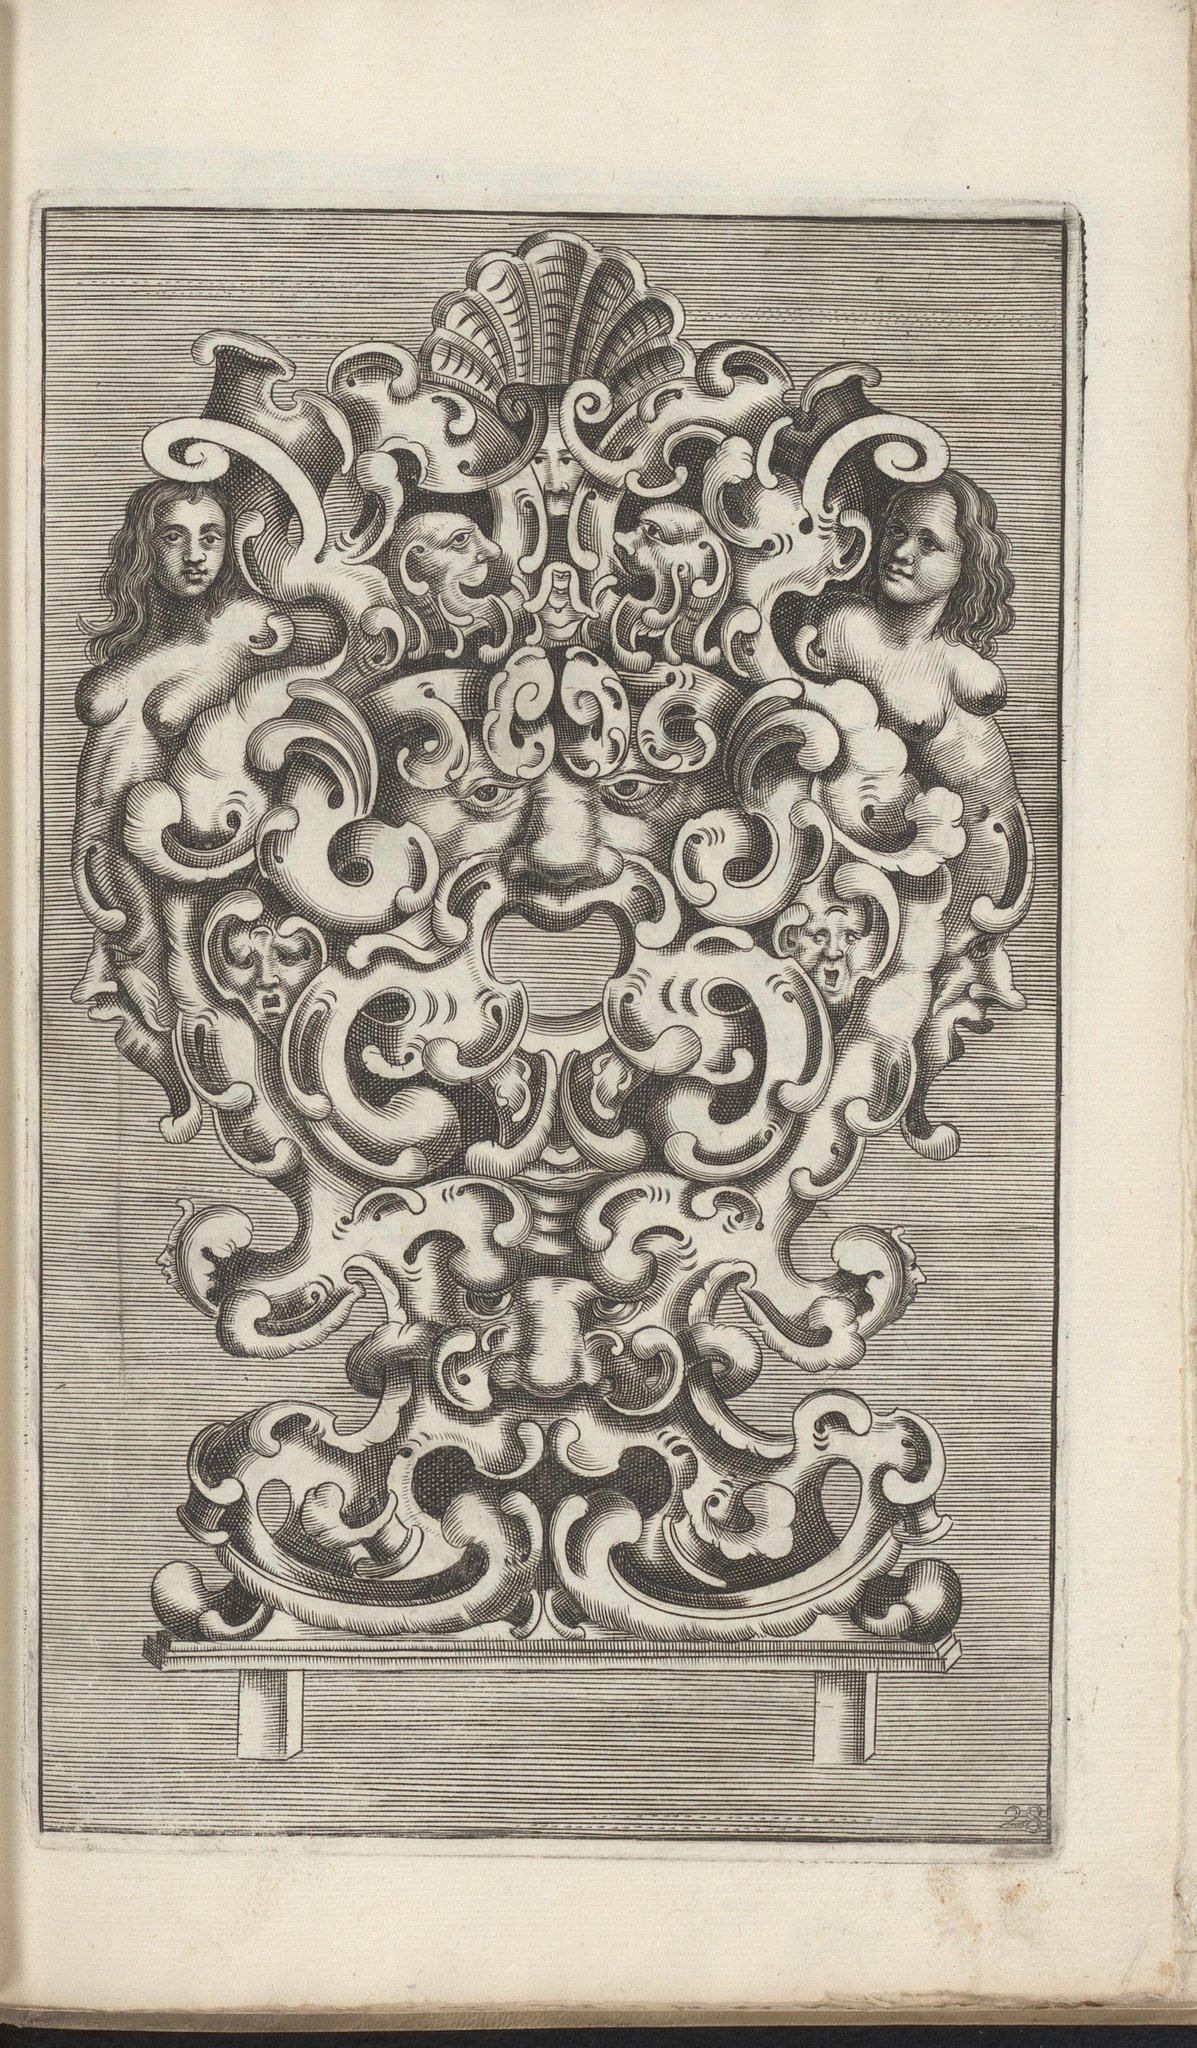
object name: ornament print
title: Stoelrug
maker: Anonymous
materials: paper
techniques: engraving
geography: wemding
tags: auricular ornament, lobe style ~ ornament, chair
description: Deze prent maakt deel uit van een album.